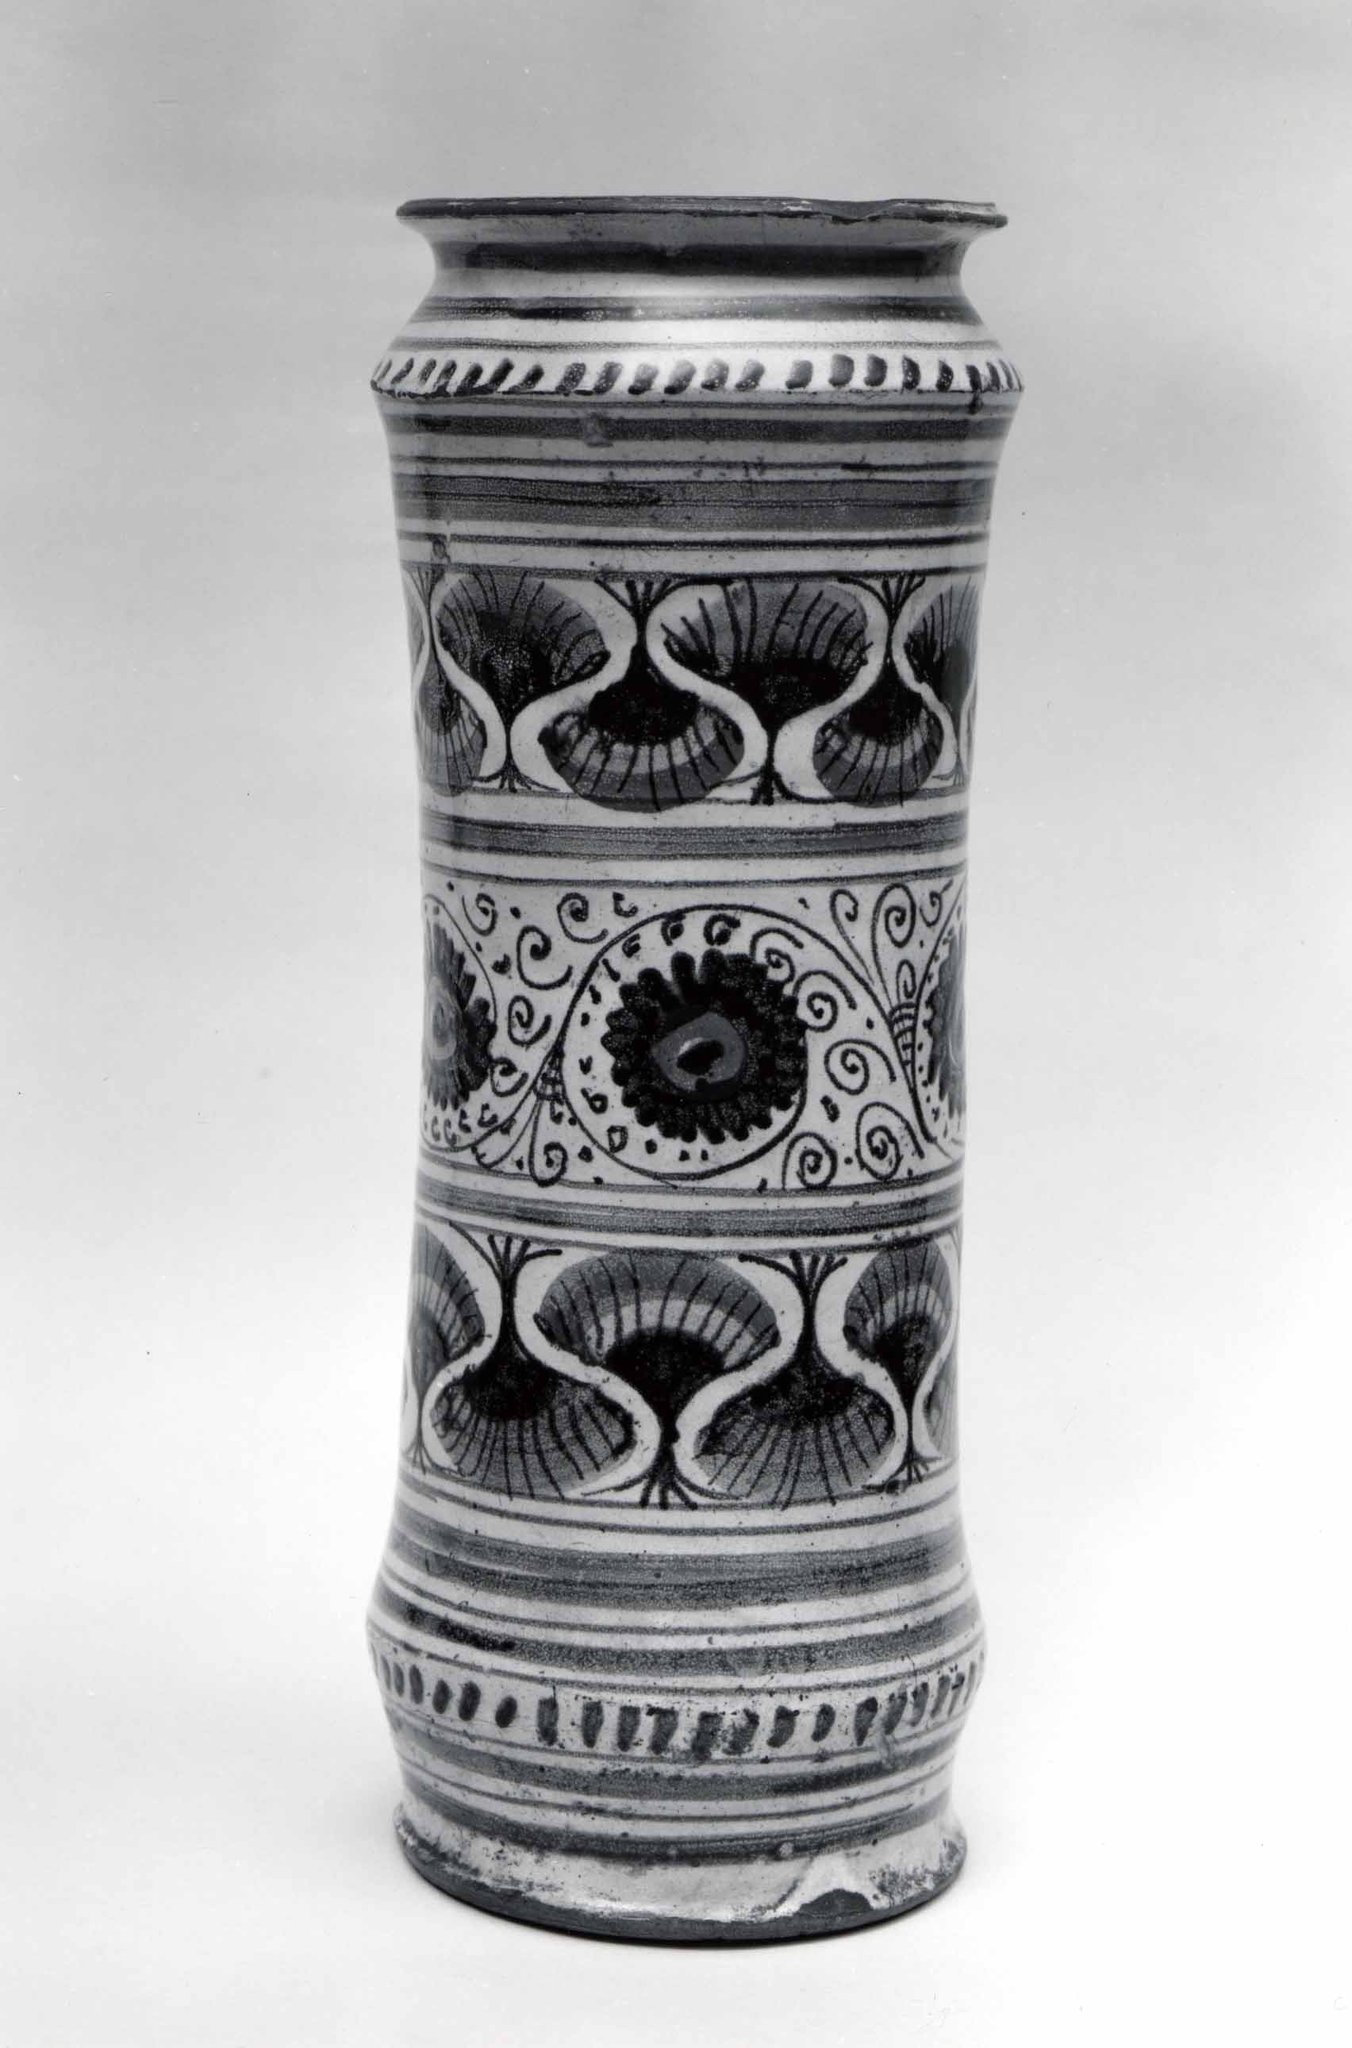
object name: albarello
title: Apothecary jar (albarello)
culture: italian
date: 1480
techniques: maiolica, glazing